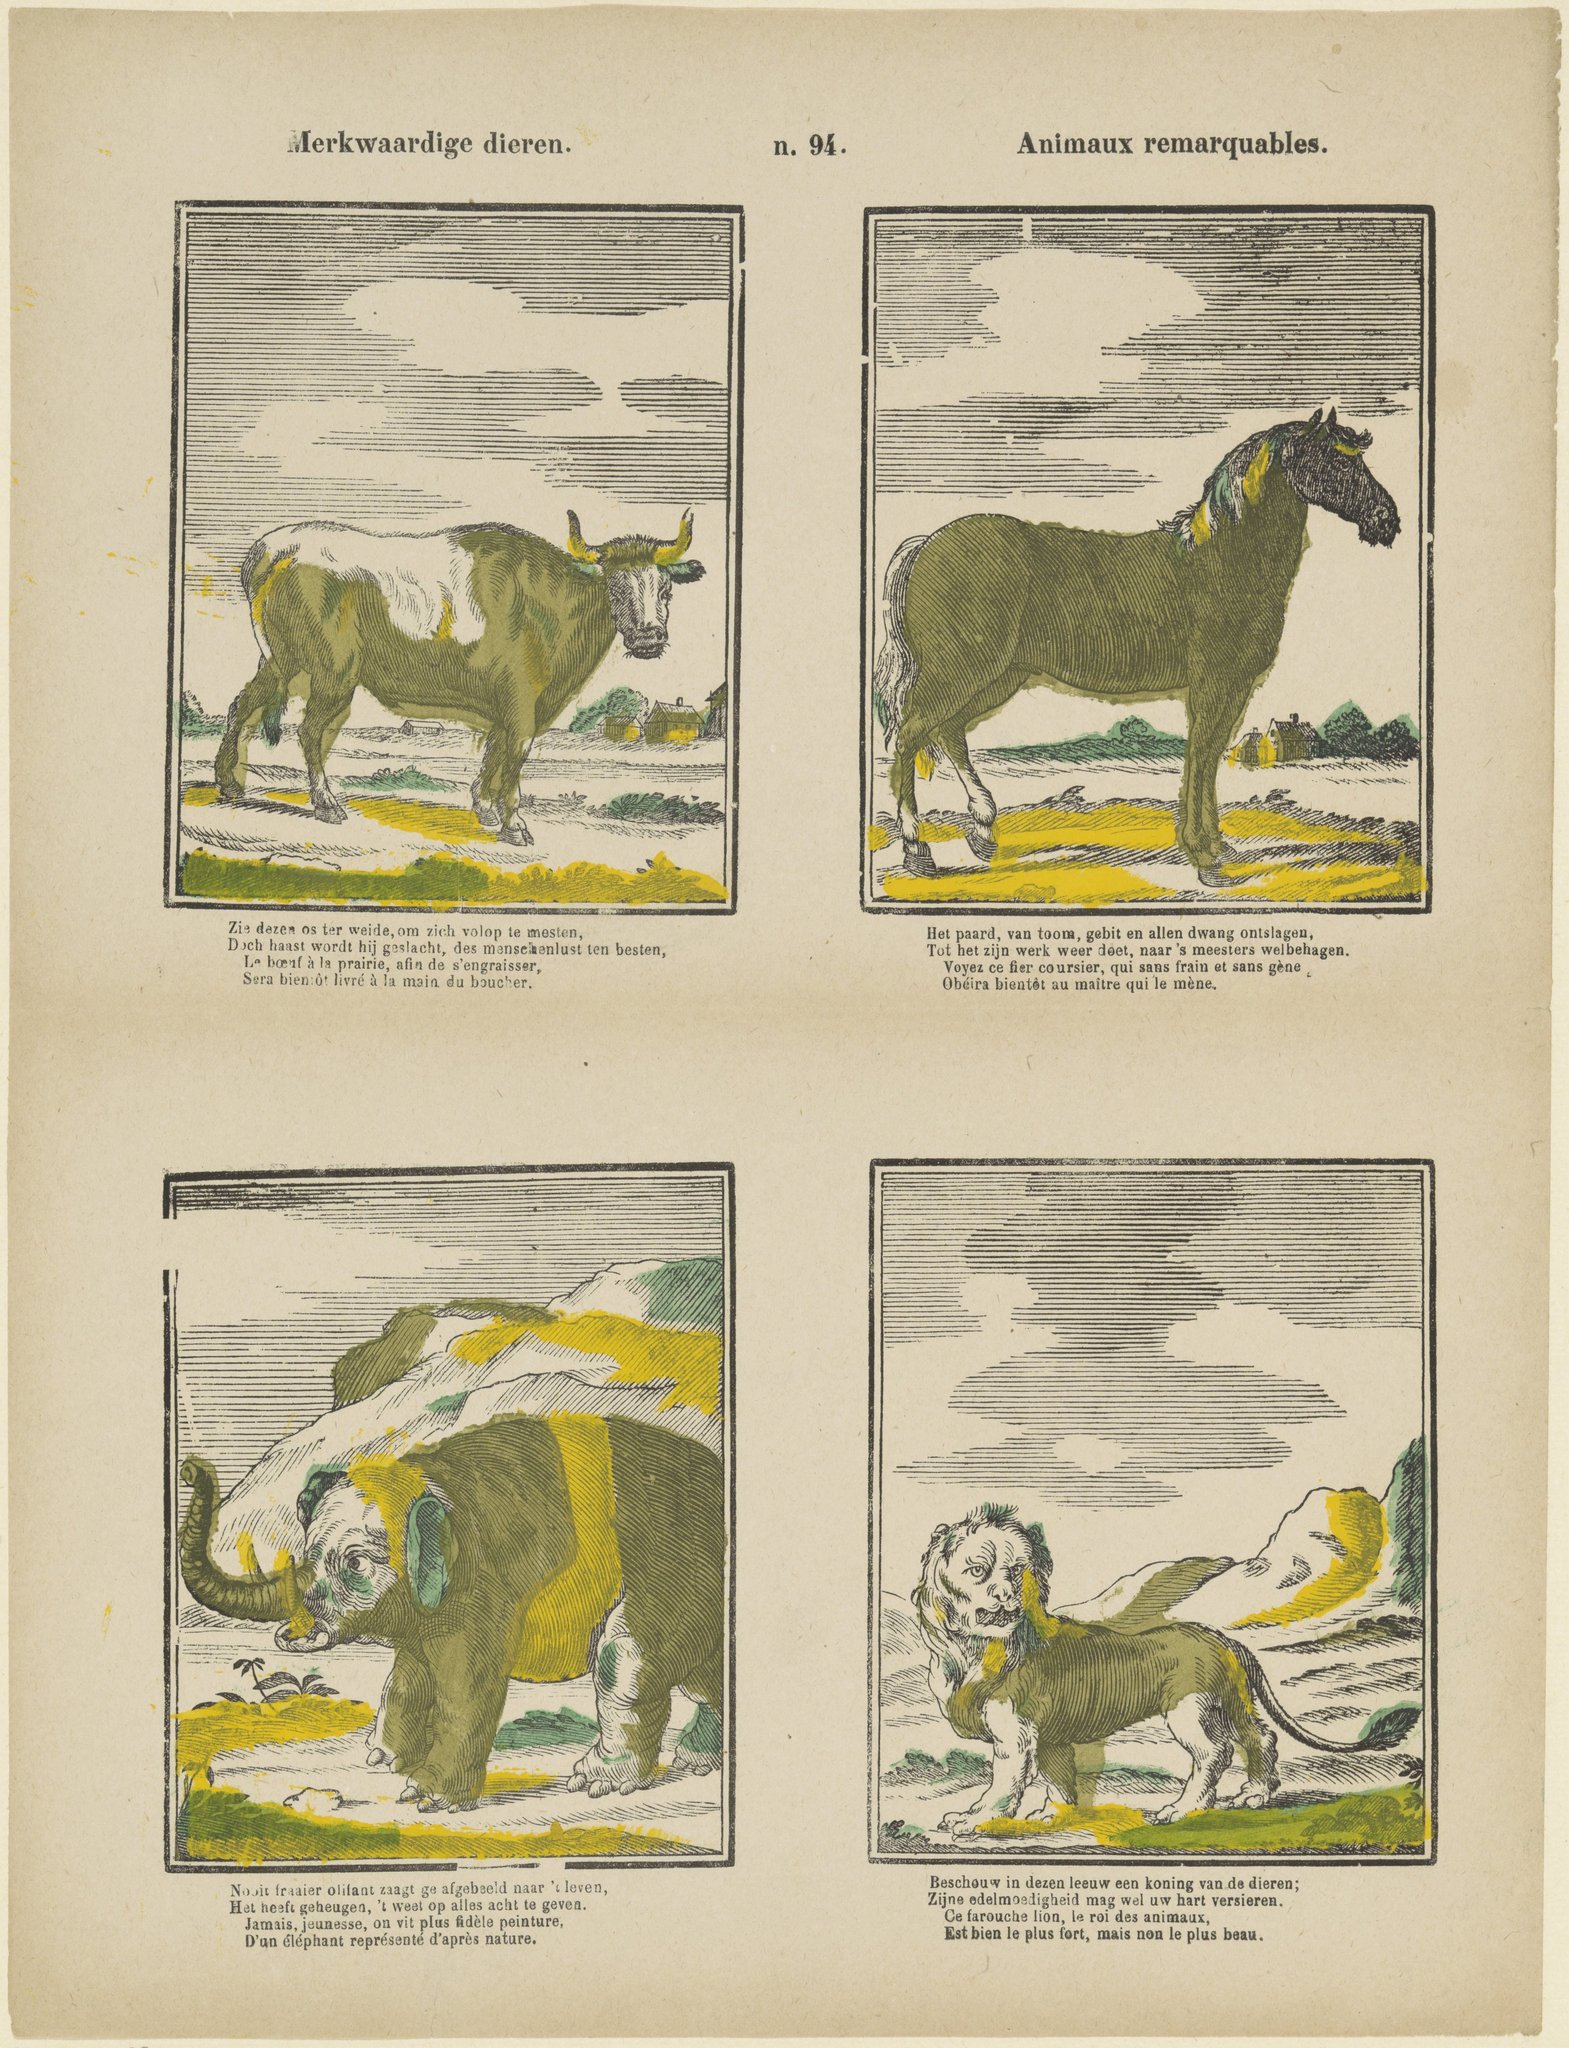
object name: popular print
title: Merkwaardige dieren / Animaux remarquables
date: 1866-1902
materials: paper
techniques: colour, letterpress printing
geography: turnhout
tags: animals, horse, ox, beasts of prey, predatory animals: lion, trunked animals: elephant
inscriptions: collector's mark: Lugt 2760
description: Blad met 4 voorstellingen van dieren: een os, een paard, een olifant en een leeuw. Onder elke afbeelding een tweeregelig vers in het Nederlands en in het Frans. Genummerd midden boven: n. 94.